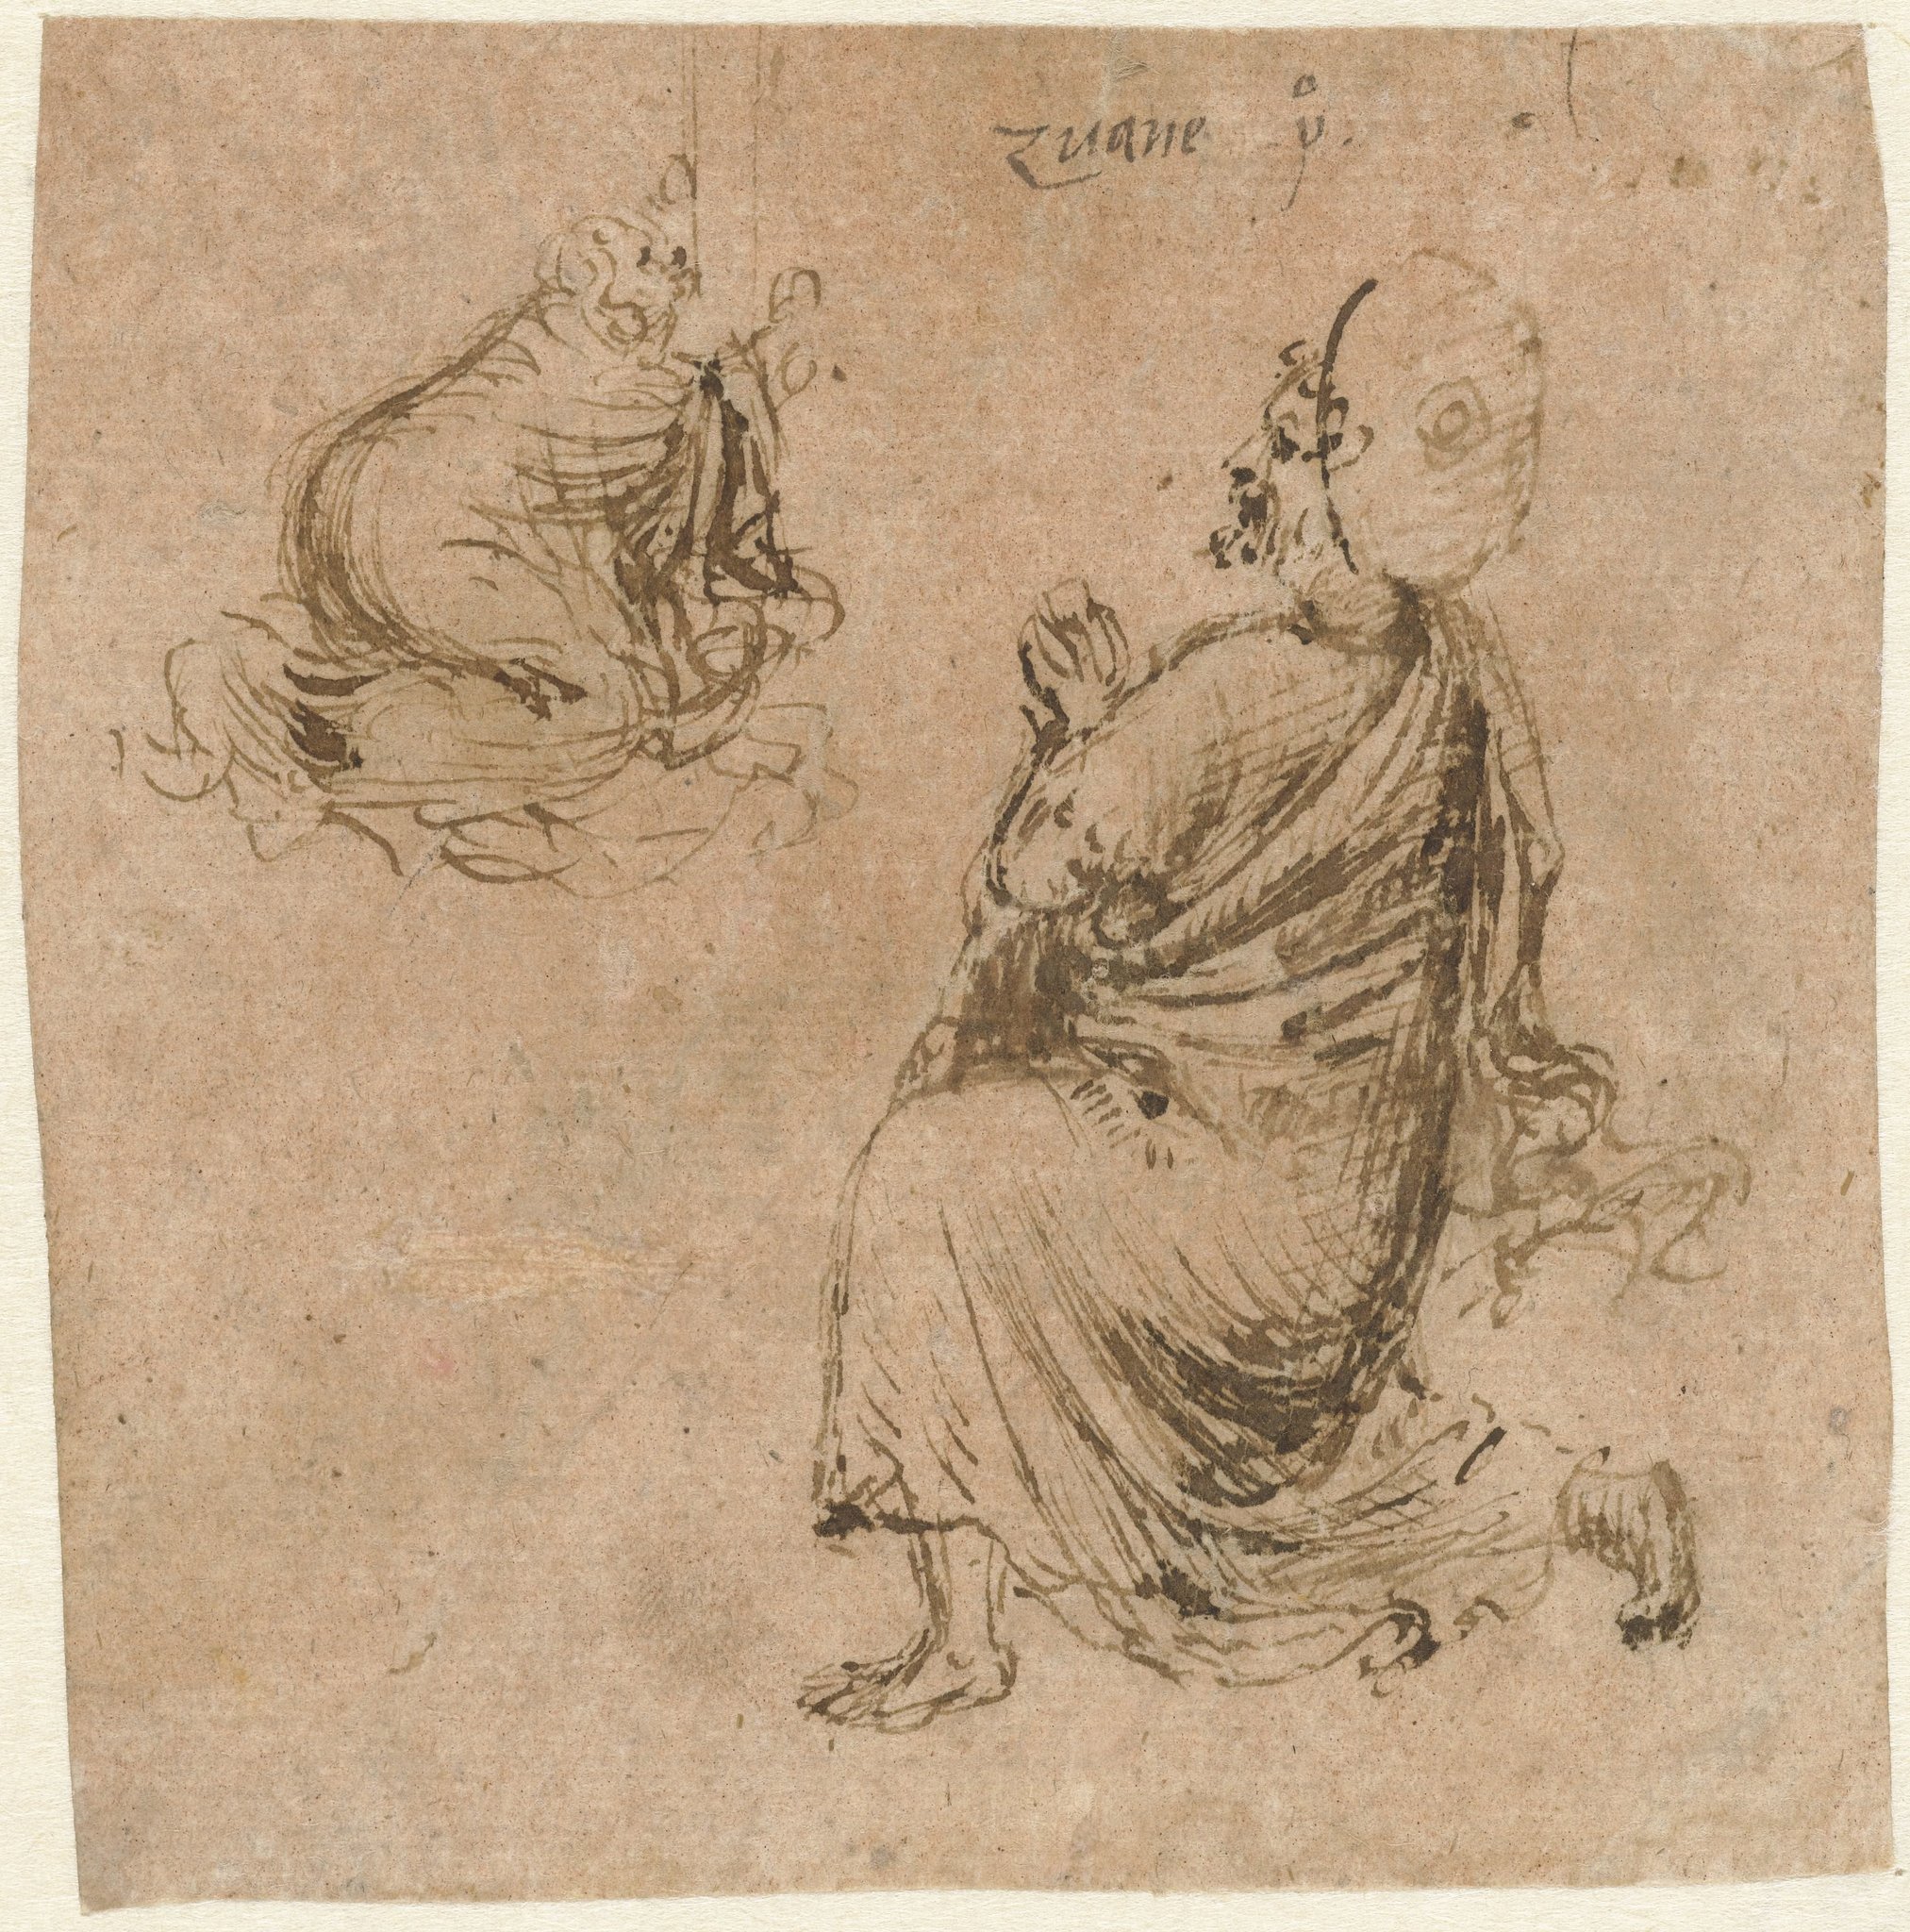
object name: drawing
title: Maria Magdalena aan de voet van het kruis en de knielende Johannes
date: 1450-1474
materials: ink, paper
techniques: pen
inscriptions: : ‘zuane p°’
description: Blad uit een album met tekeningen van 15de-eeuwse kunstenaars uit Verona, Padua en Venetië.